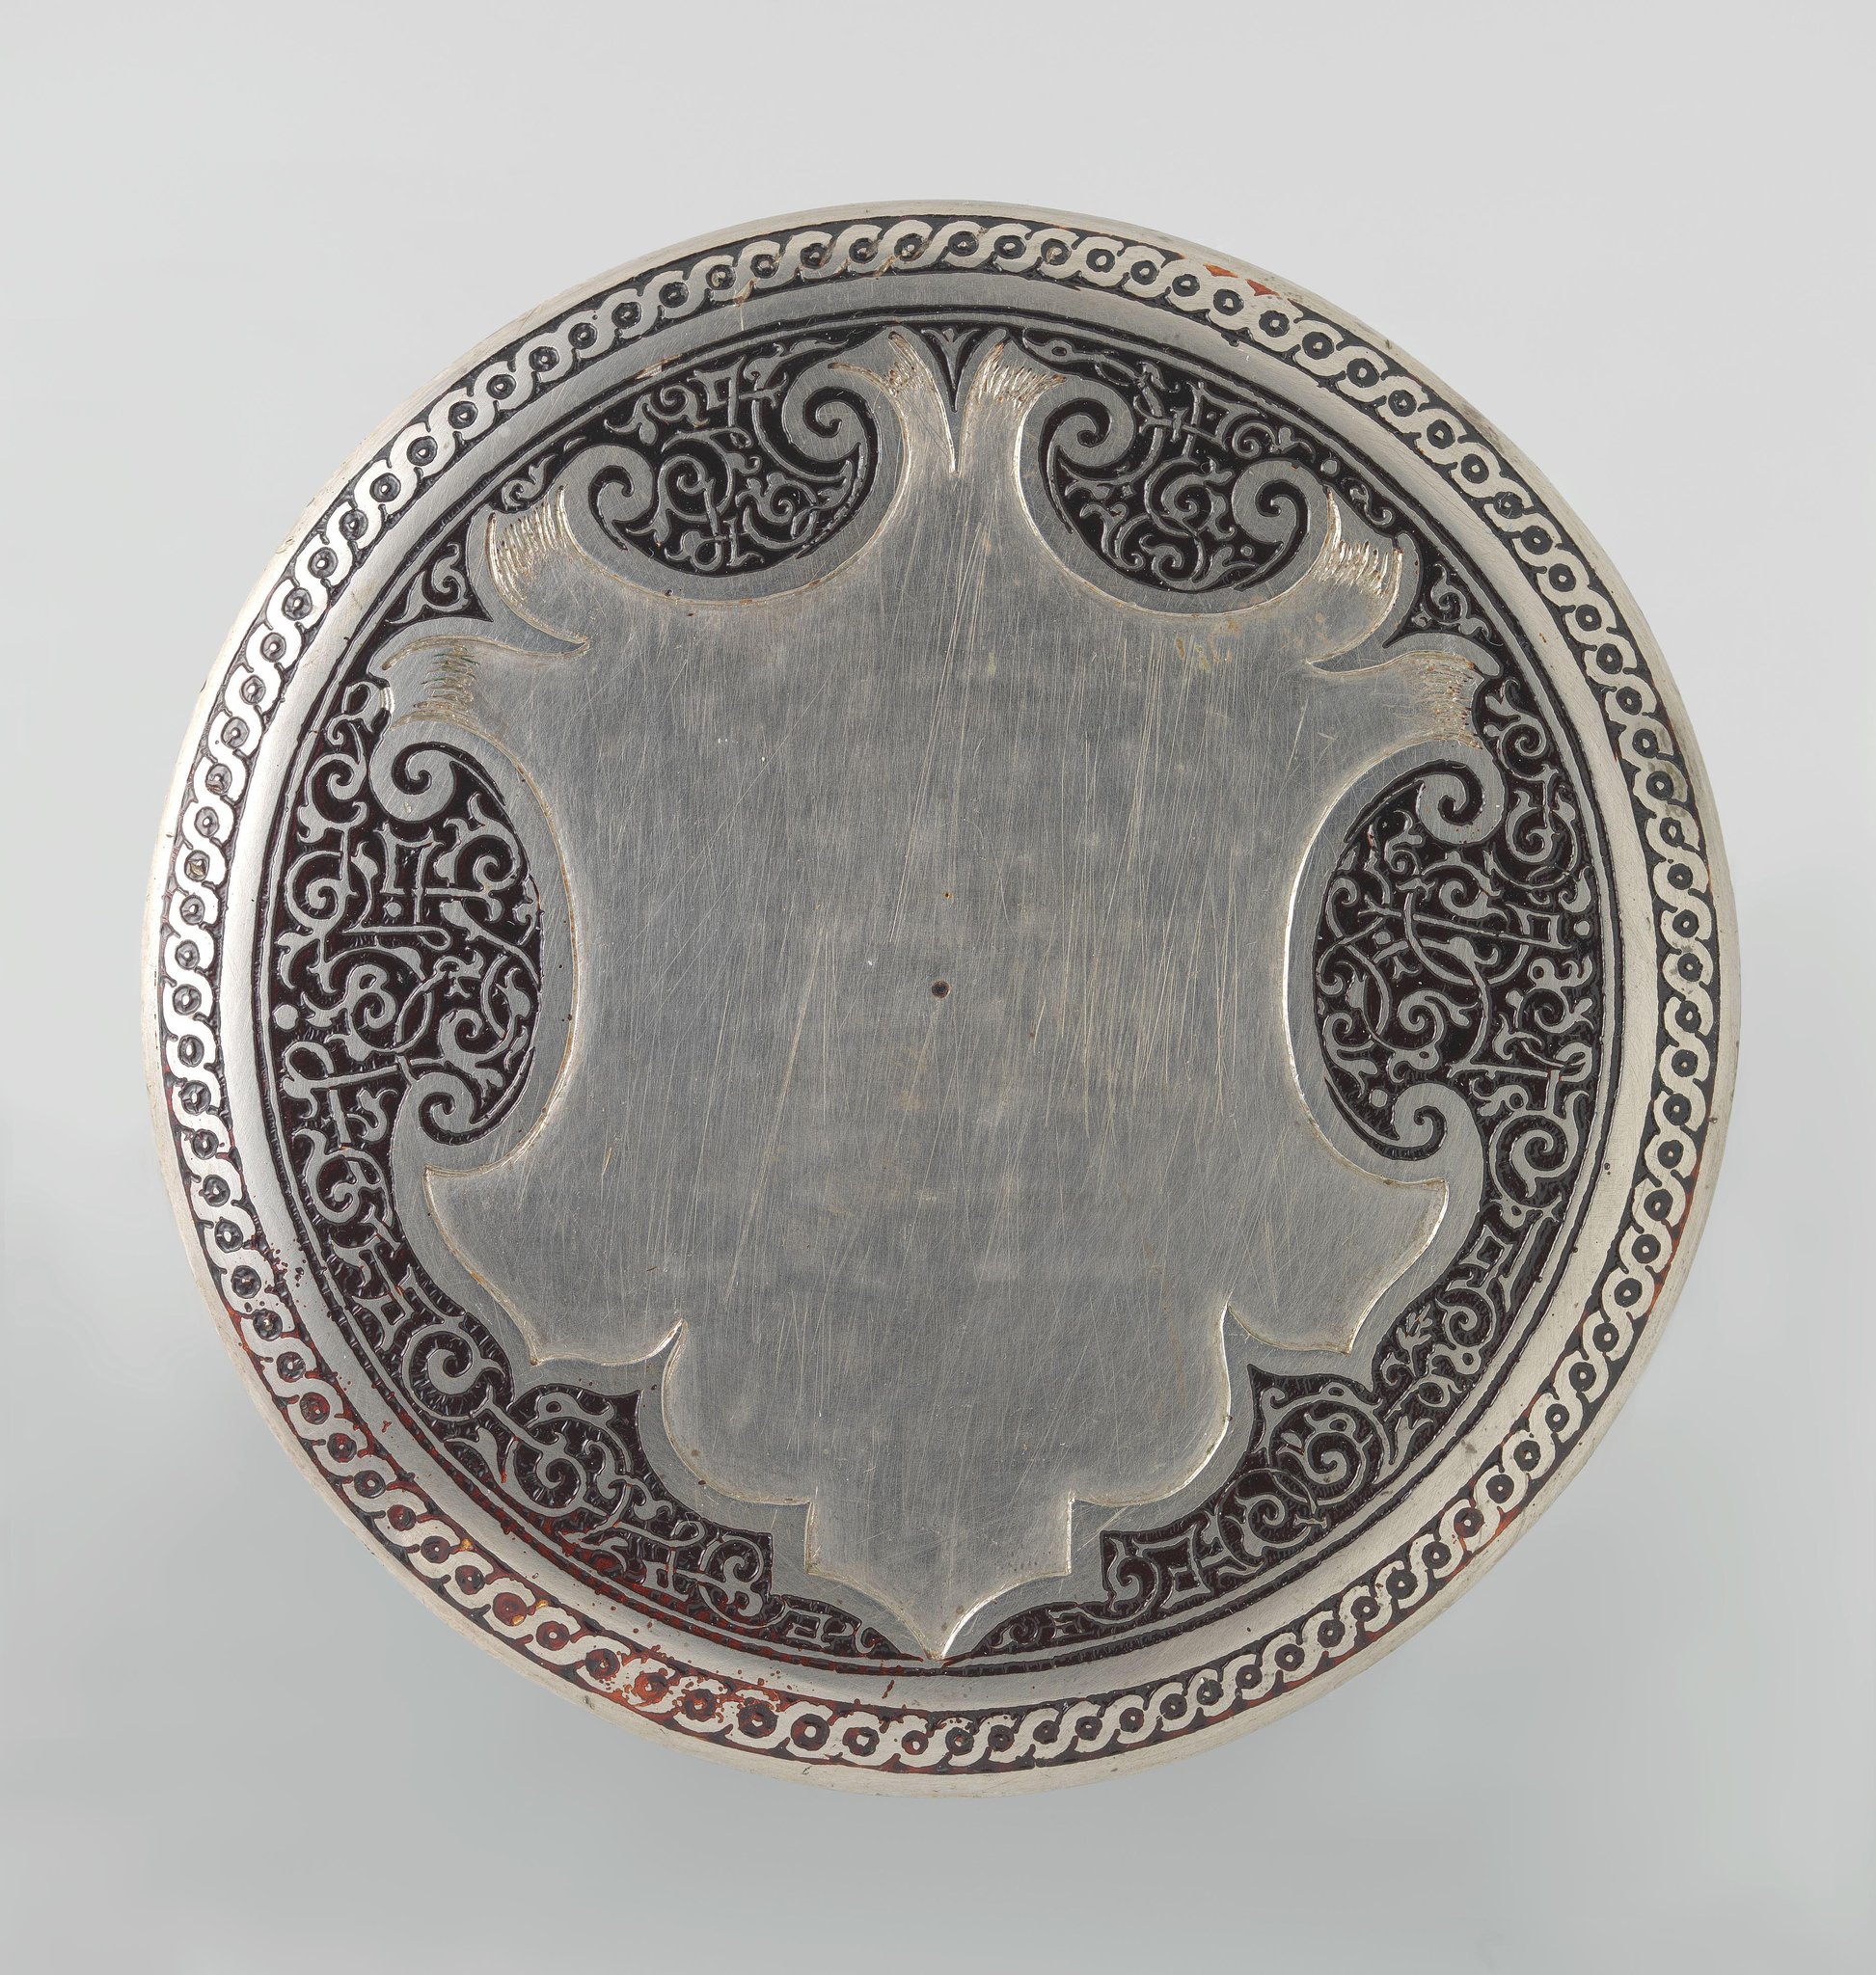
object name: plaque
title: Plaquette van de Merkelsche Tafelaufsatz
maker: wenzel jamnitzer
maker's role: print maker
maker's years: 1508-1585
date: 1549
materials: silver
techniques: casting, etching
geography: nuremberg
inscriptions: town mark: ‘N’, maker's mark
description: Plaquette die onder het tafelstuk gemonteerd heeft gezeten. Op deze plaquette heeft vroeger een tekst gestaan, die weer is verwijderd.